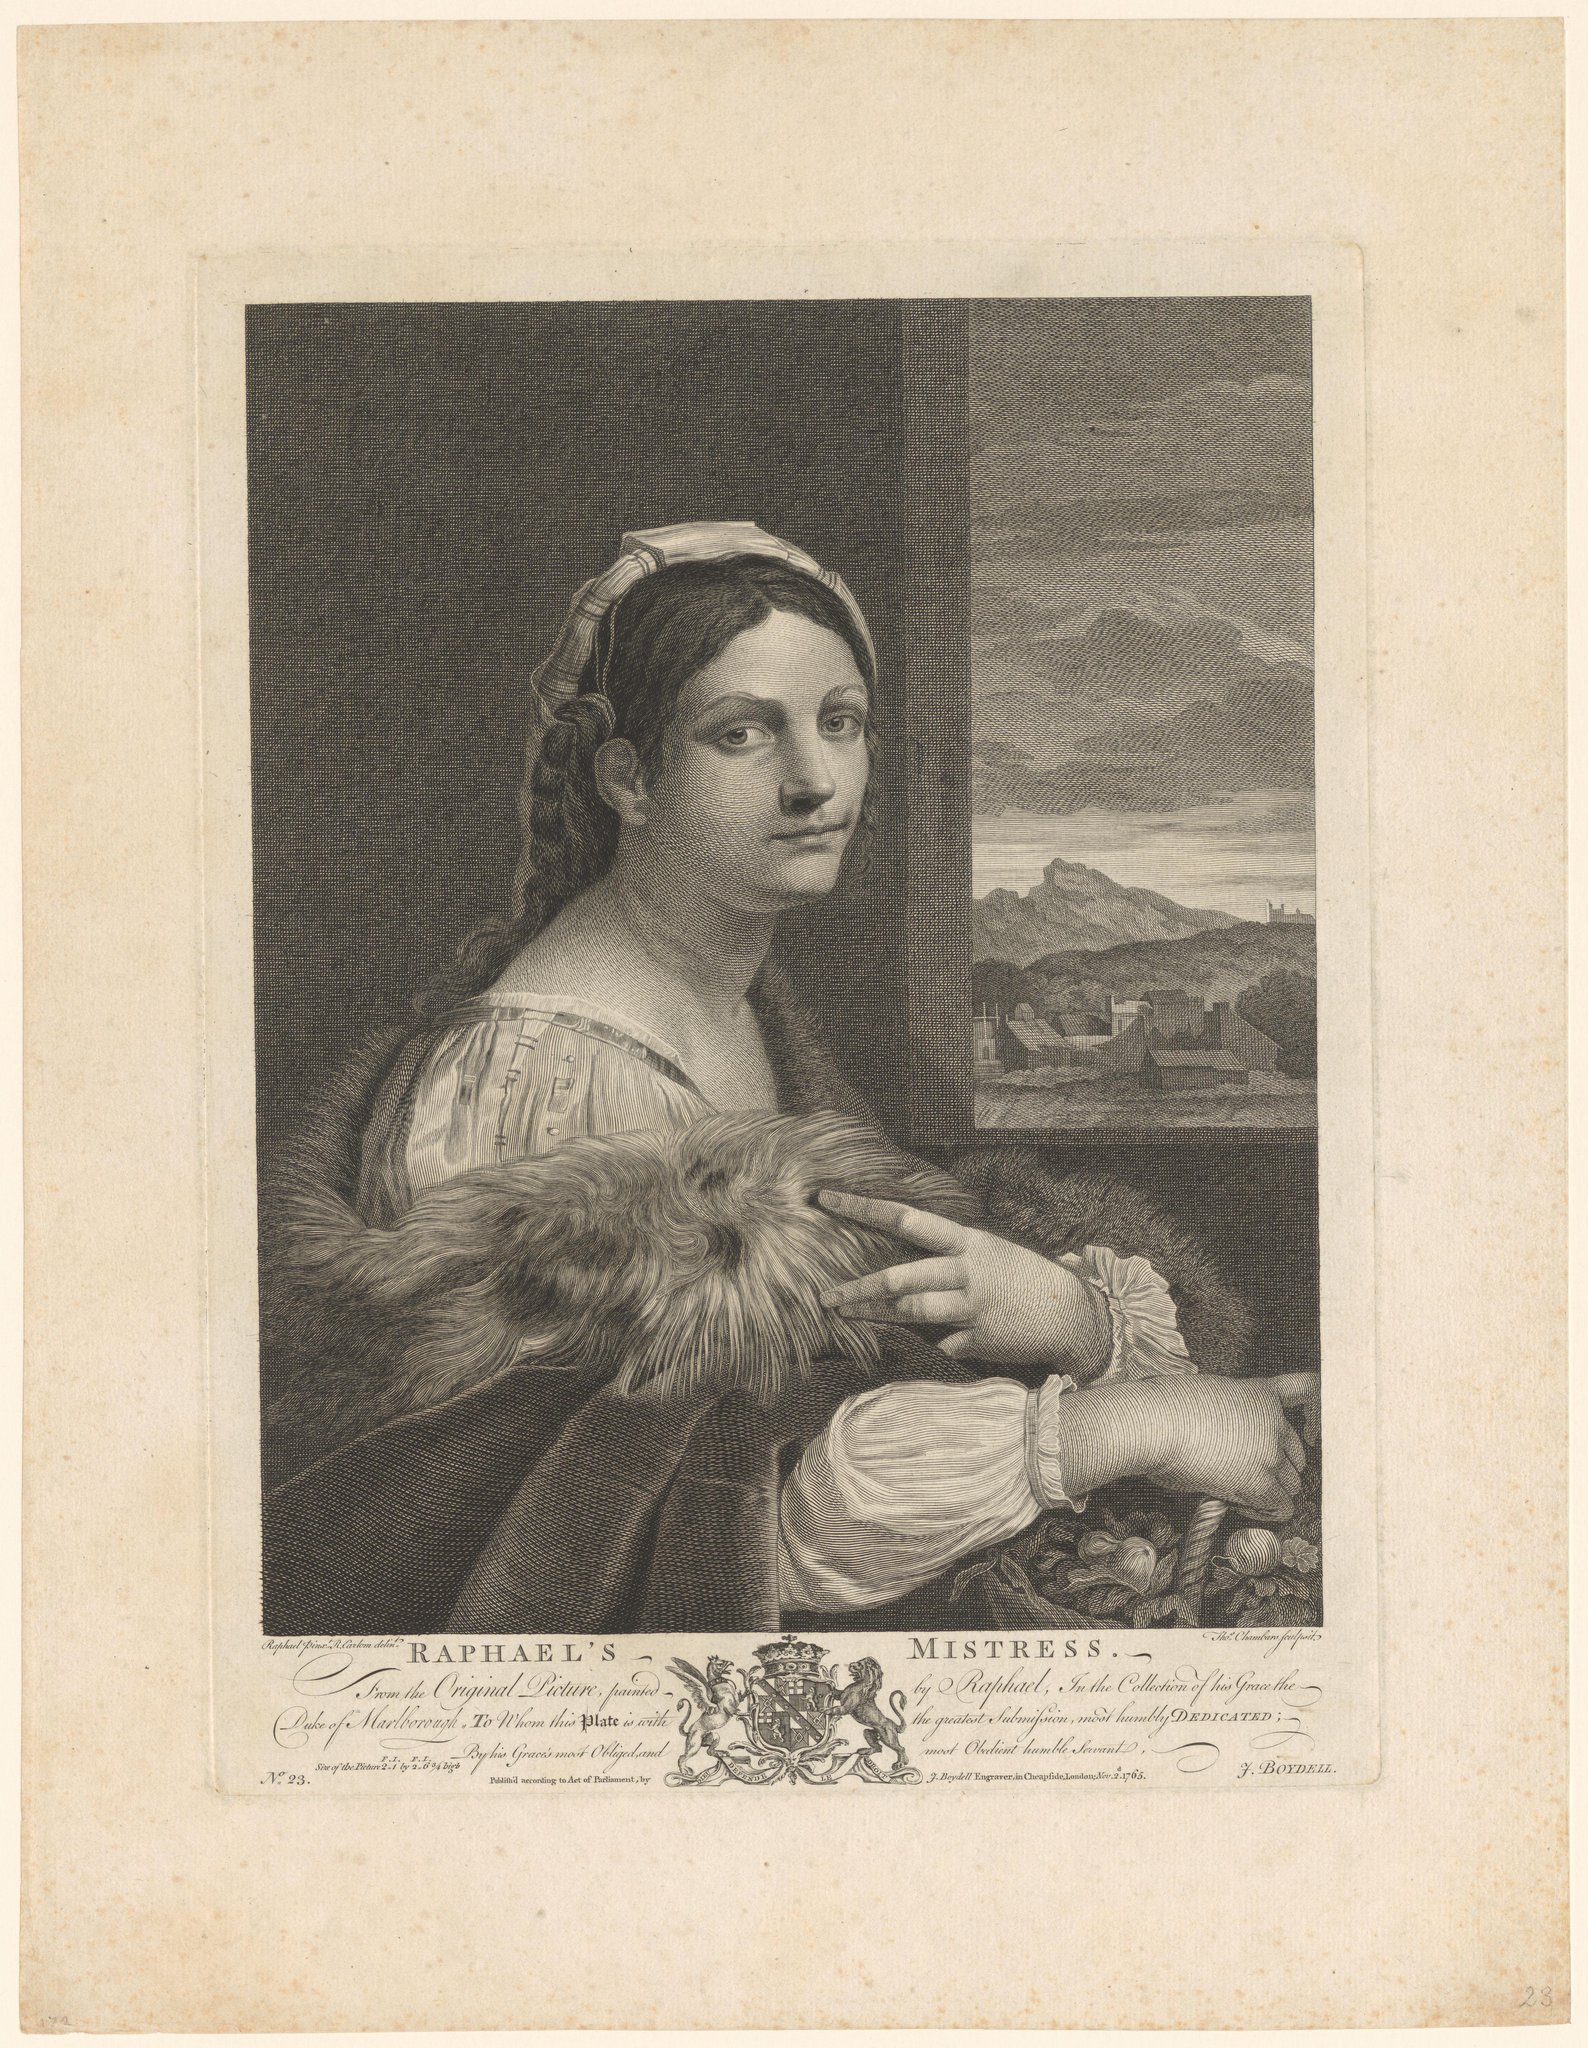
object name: print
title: Raphael's Mistress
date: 1765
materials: paper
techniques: engraving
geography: london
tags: artist's model, sitter, mistress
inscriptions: collector's mark: Lugt 240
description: Margarita is bekend als het schildersmodel en de minnares van Rafaël. Genummerd: 23. Tekst in het Engels en een wapenschild in de ondermarge.